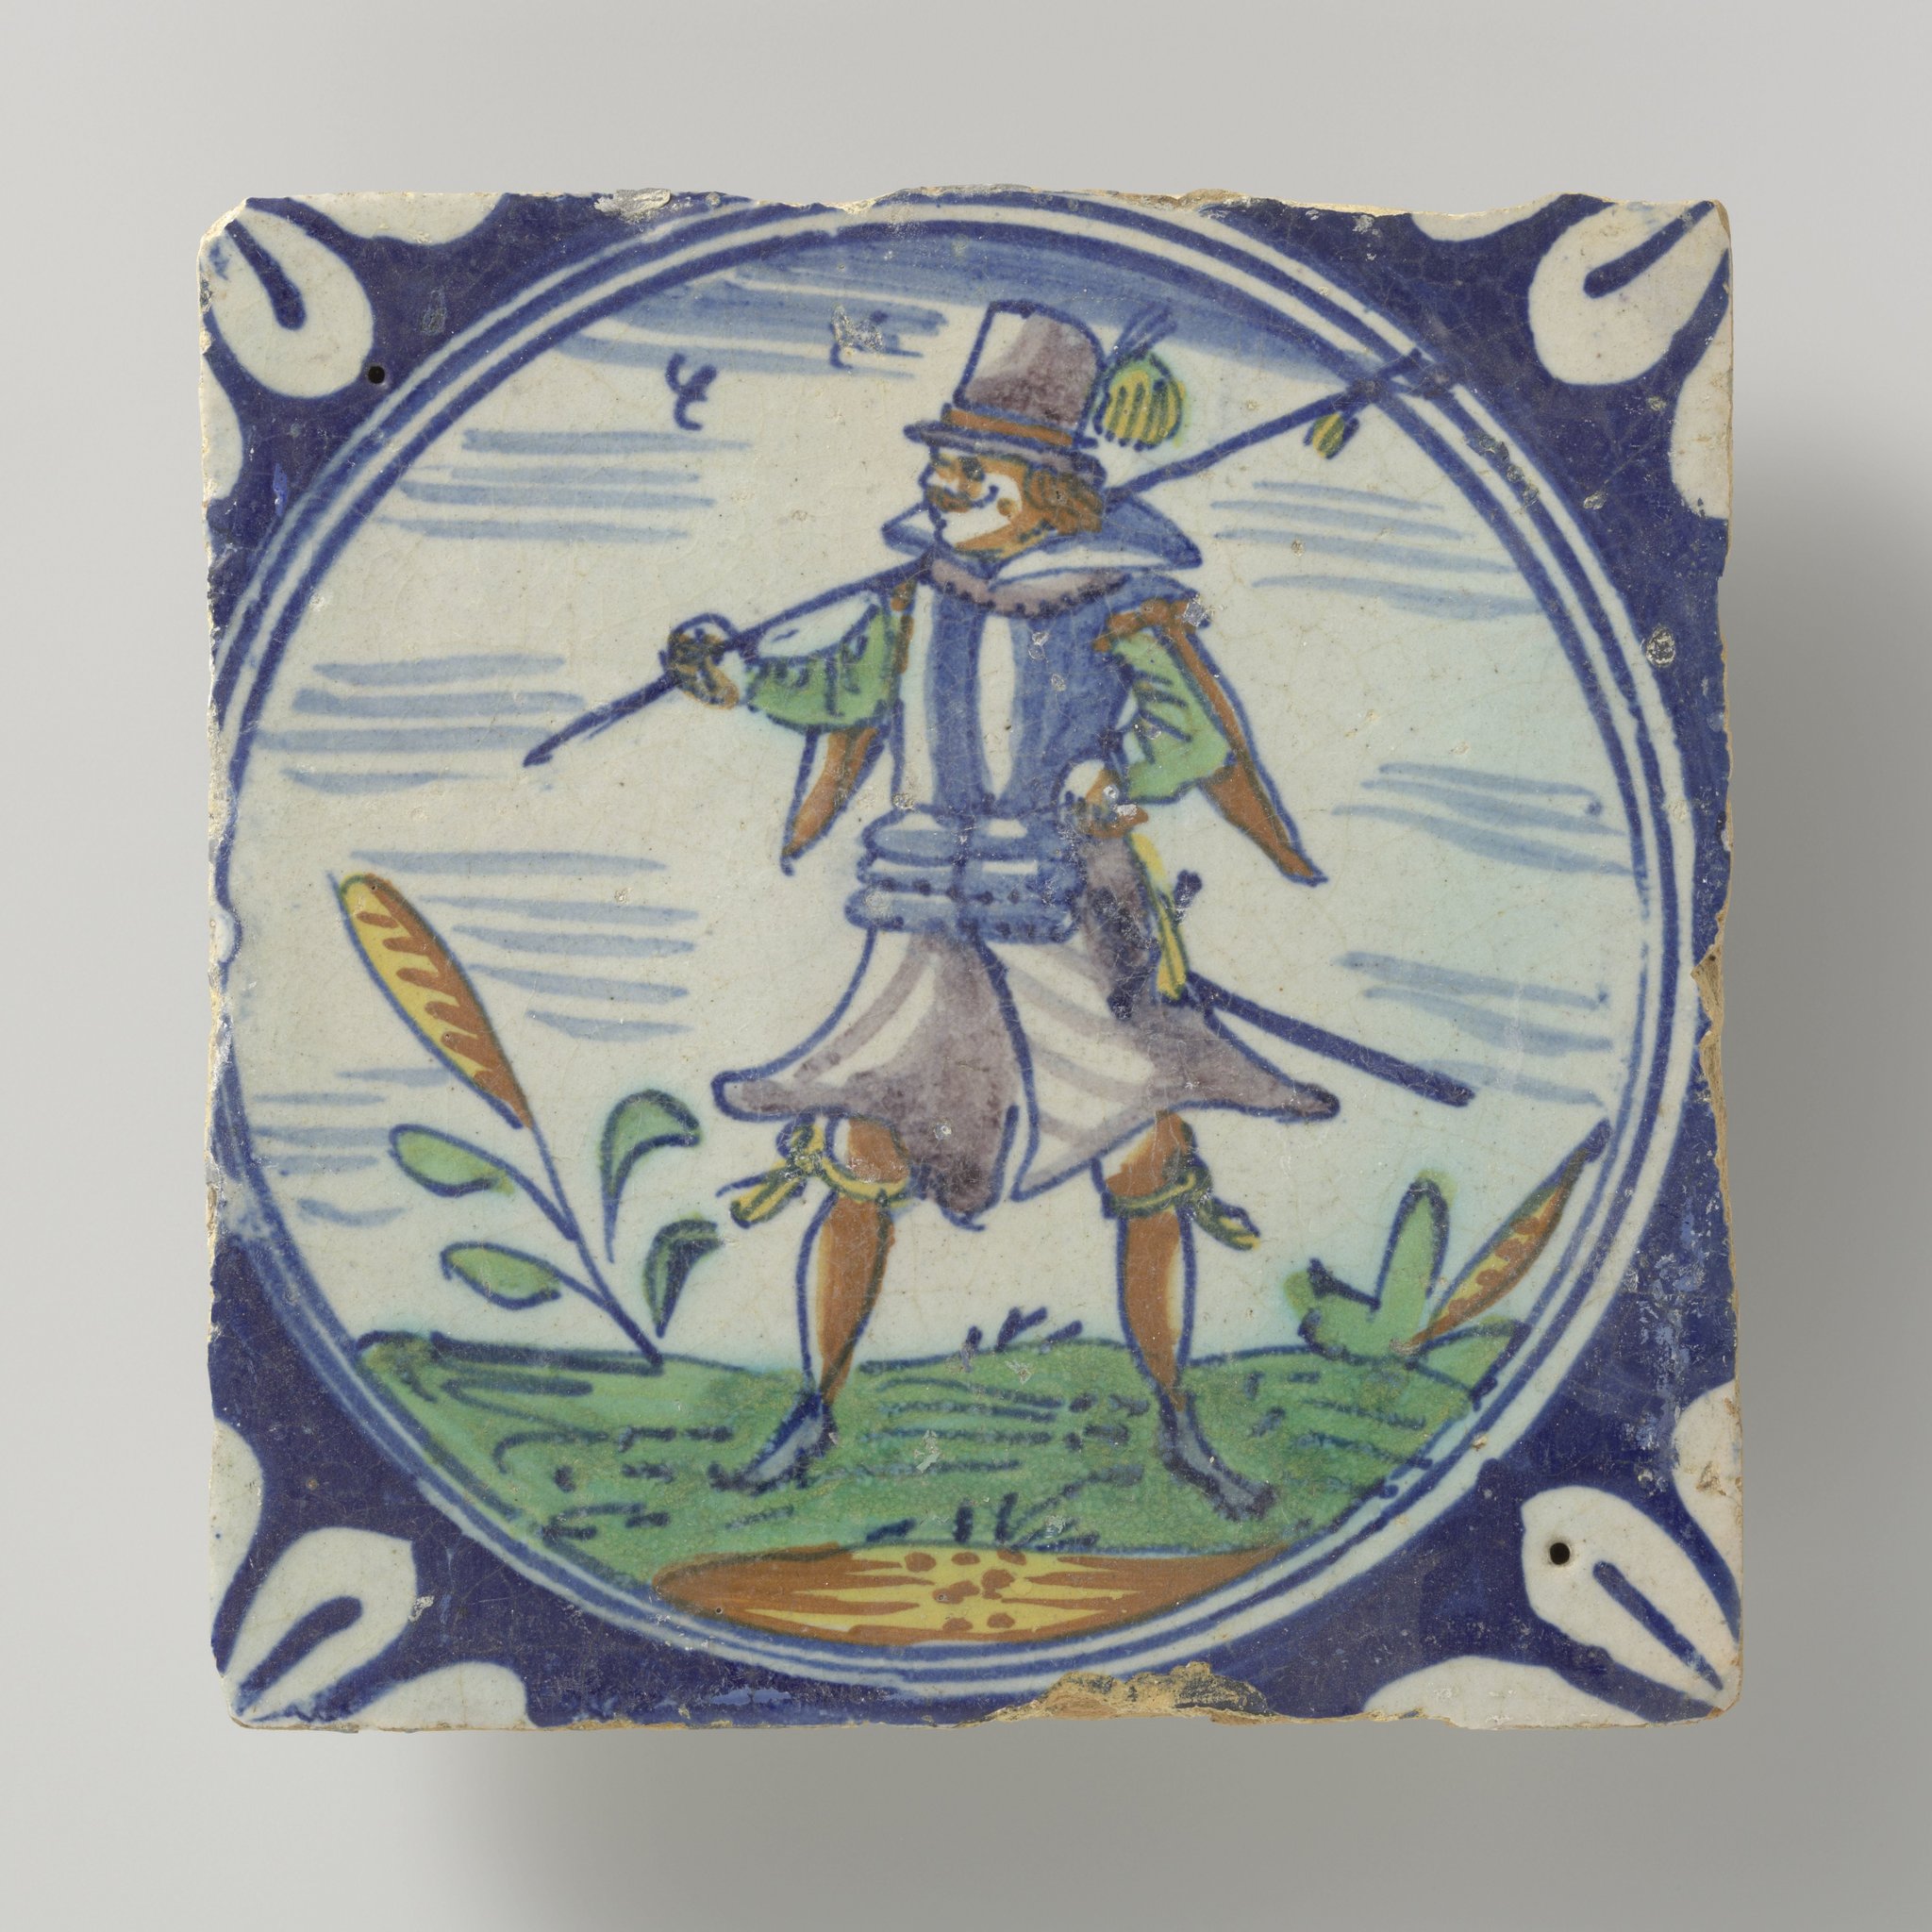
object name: tile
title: Tegel, veelkleurig beschilderd met een soldaat of een vaandeldrager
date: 1625-1700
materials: earthenware, glaze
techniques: maiolica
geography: netherlands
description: Tegel, veelkleurig beschilderd met een soldaat of een vaandeldrager.